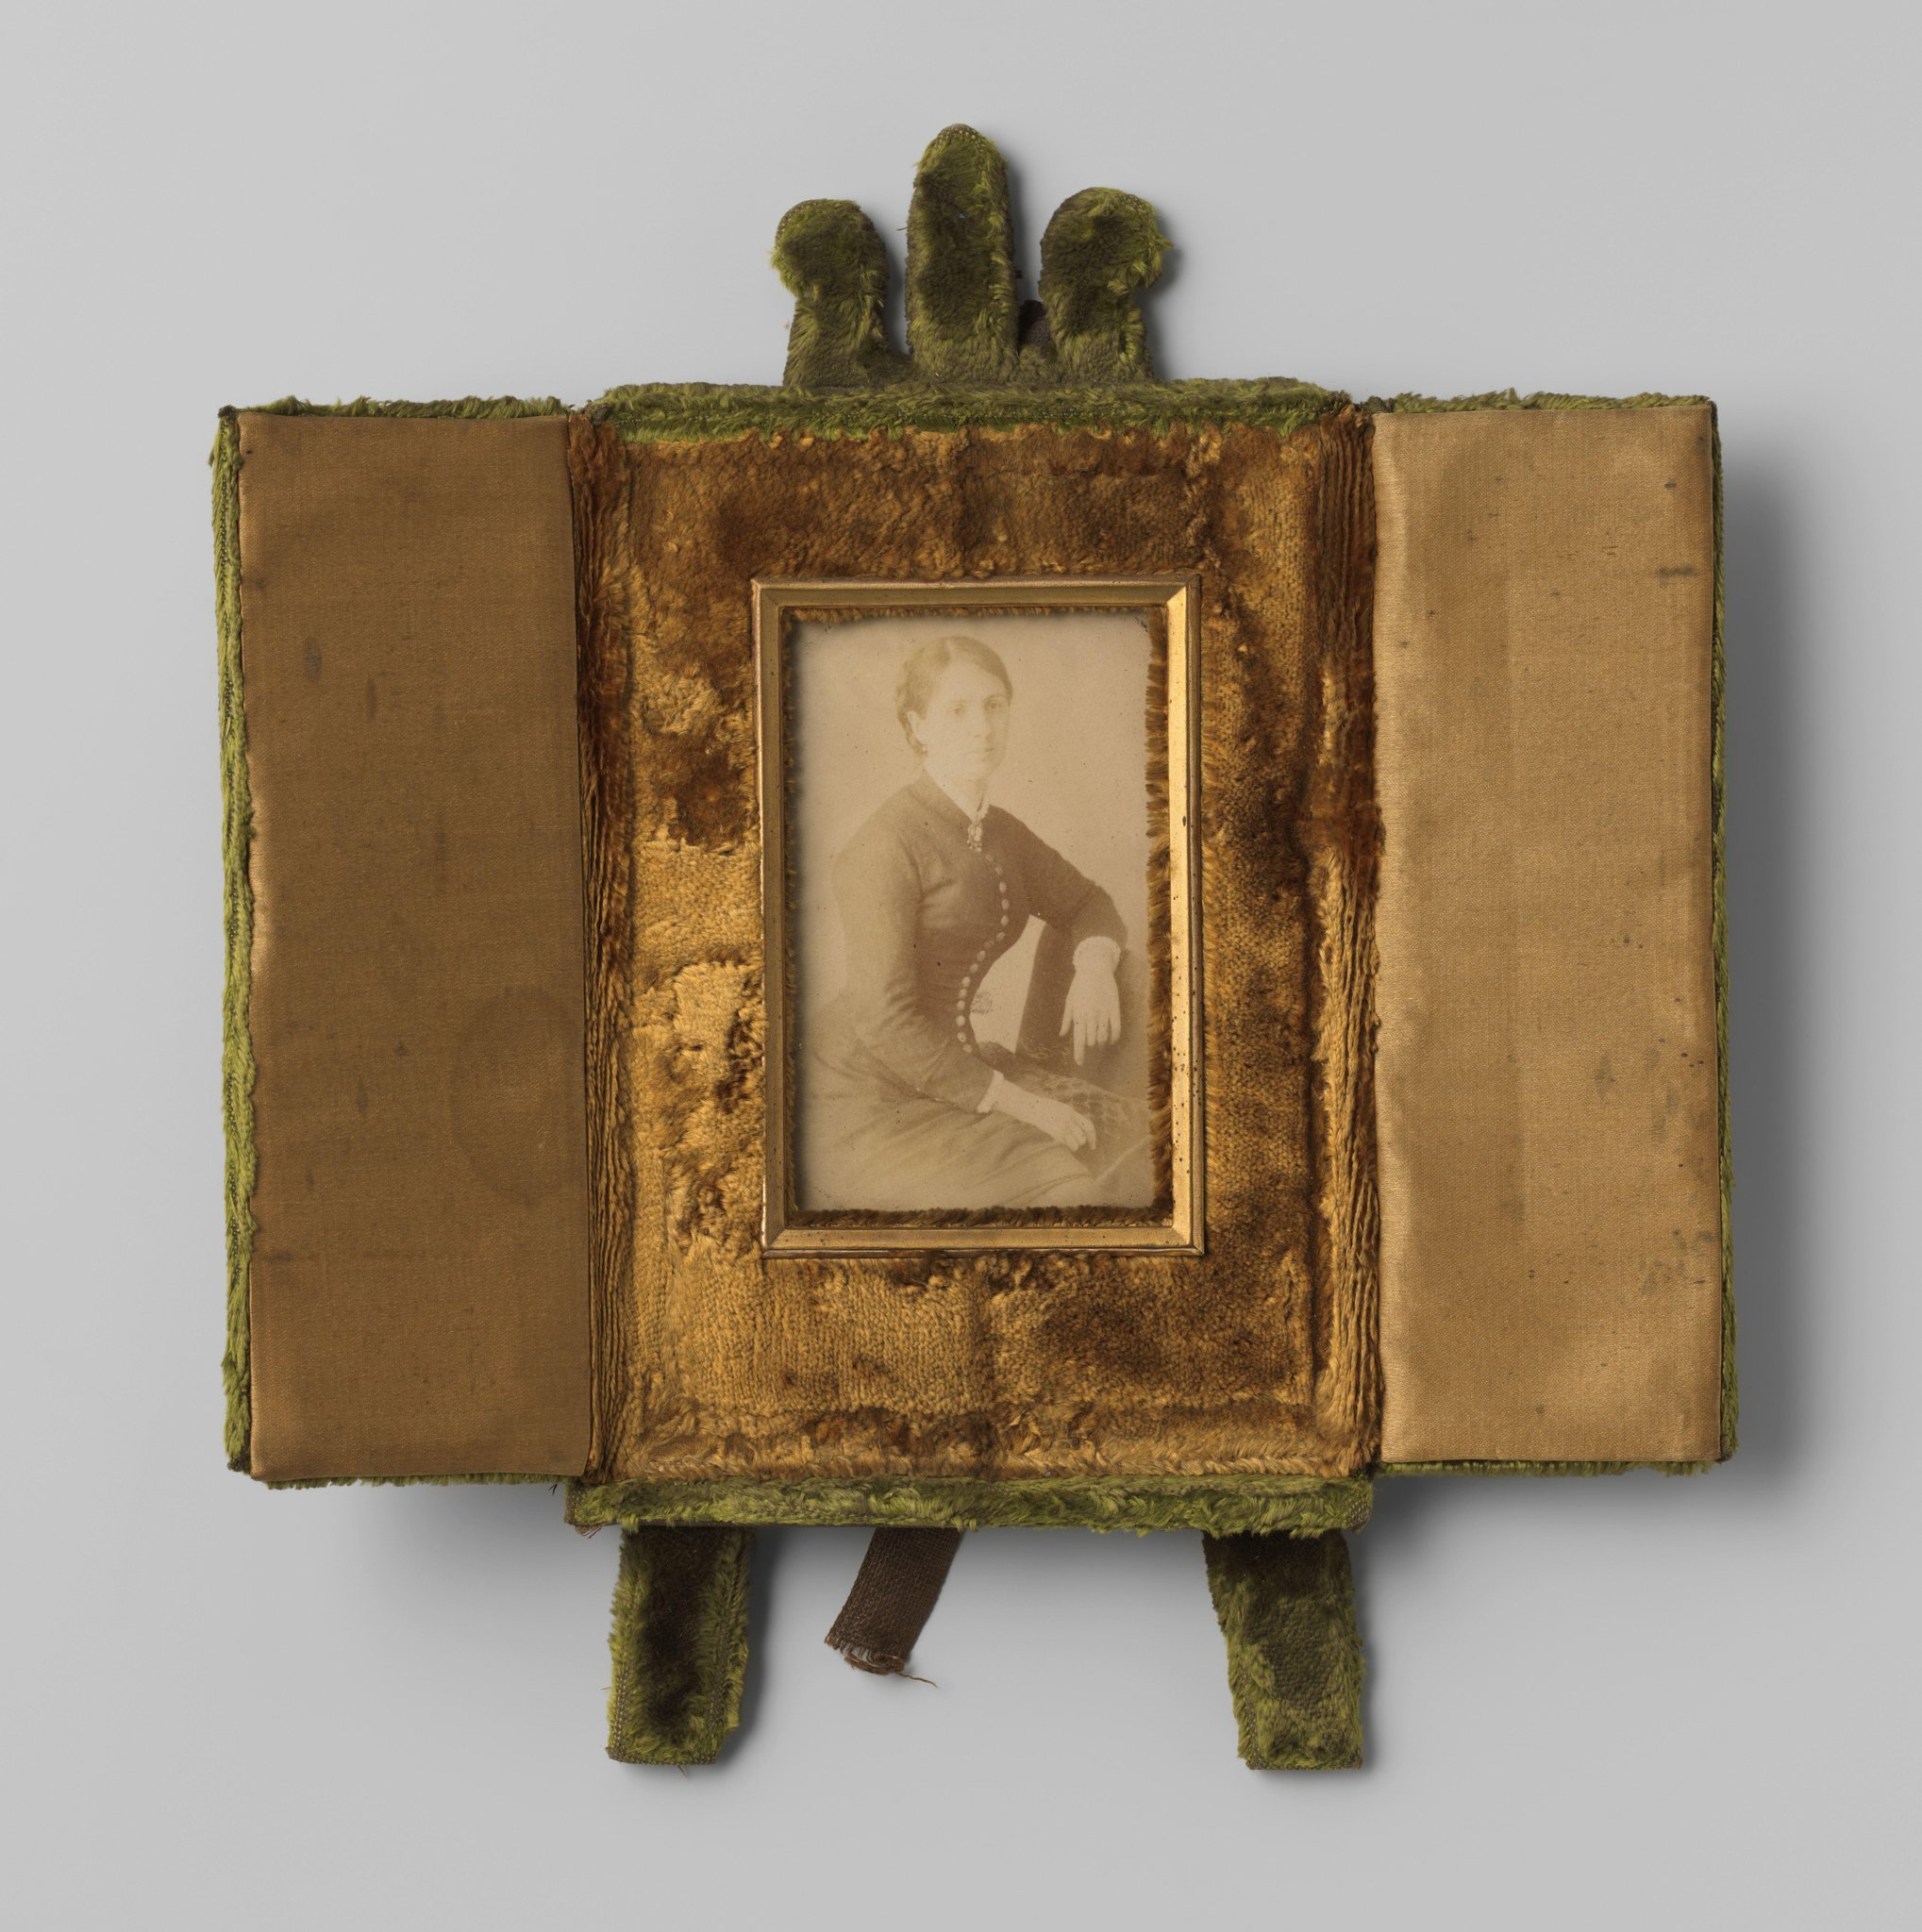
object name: photograph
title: Portret van een onbekende zittende vrouw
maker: paul beuscher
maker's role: fotograaf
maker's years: 1834-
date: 1872-1891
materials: cardboard, glass, metal, paper, textile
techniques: albumen print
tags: adult woman, anonymous historical person portrayed